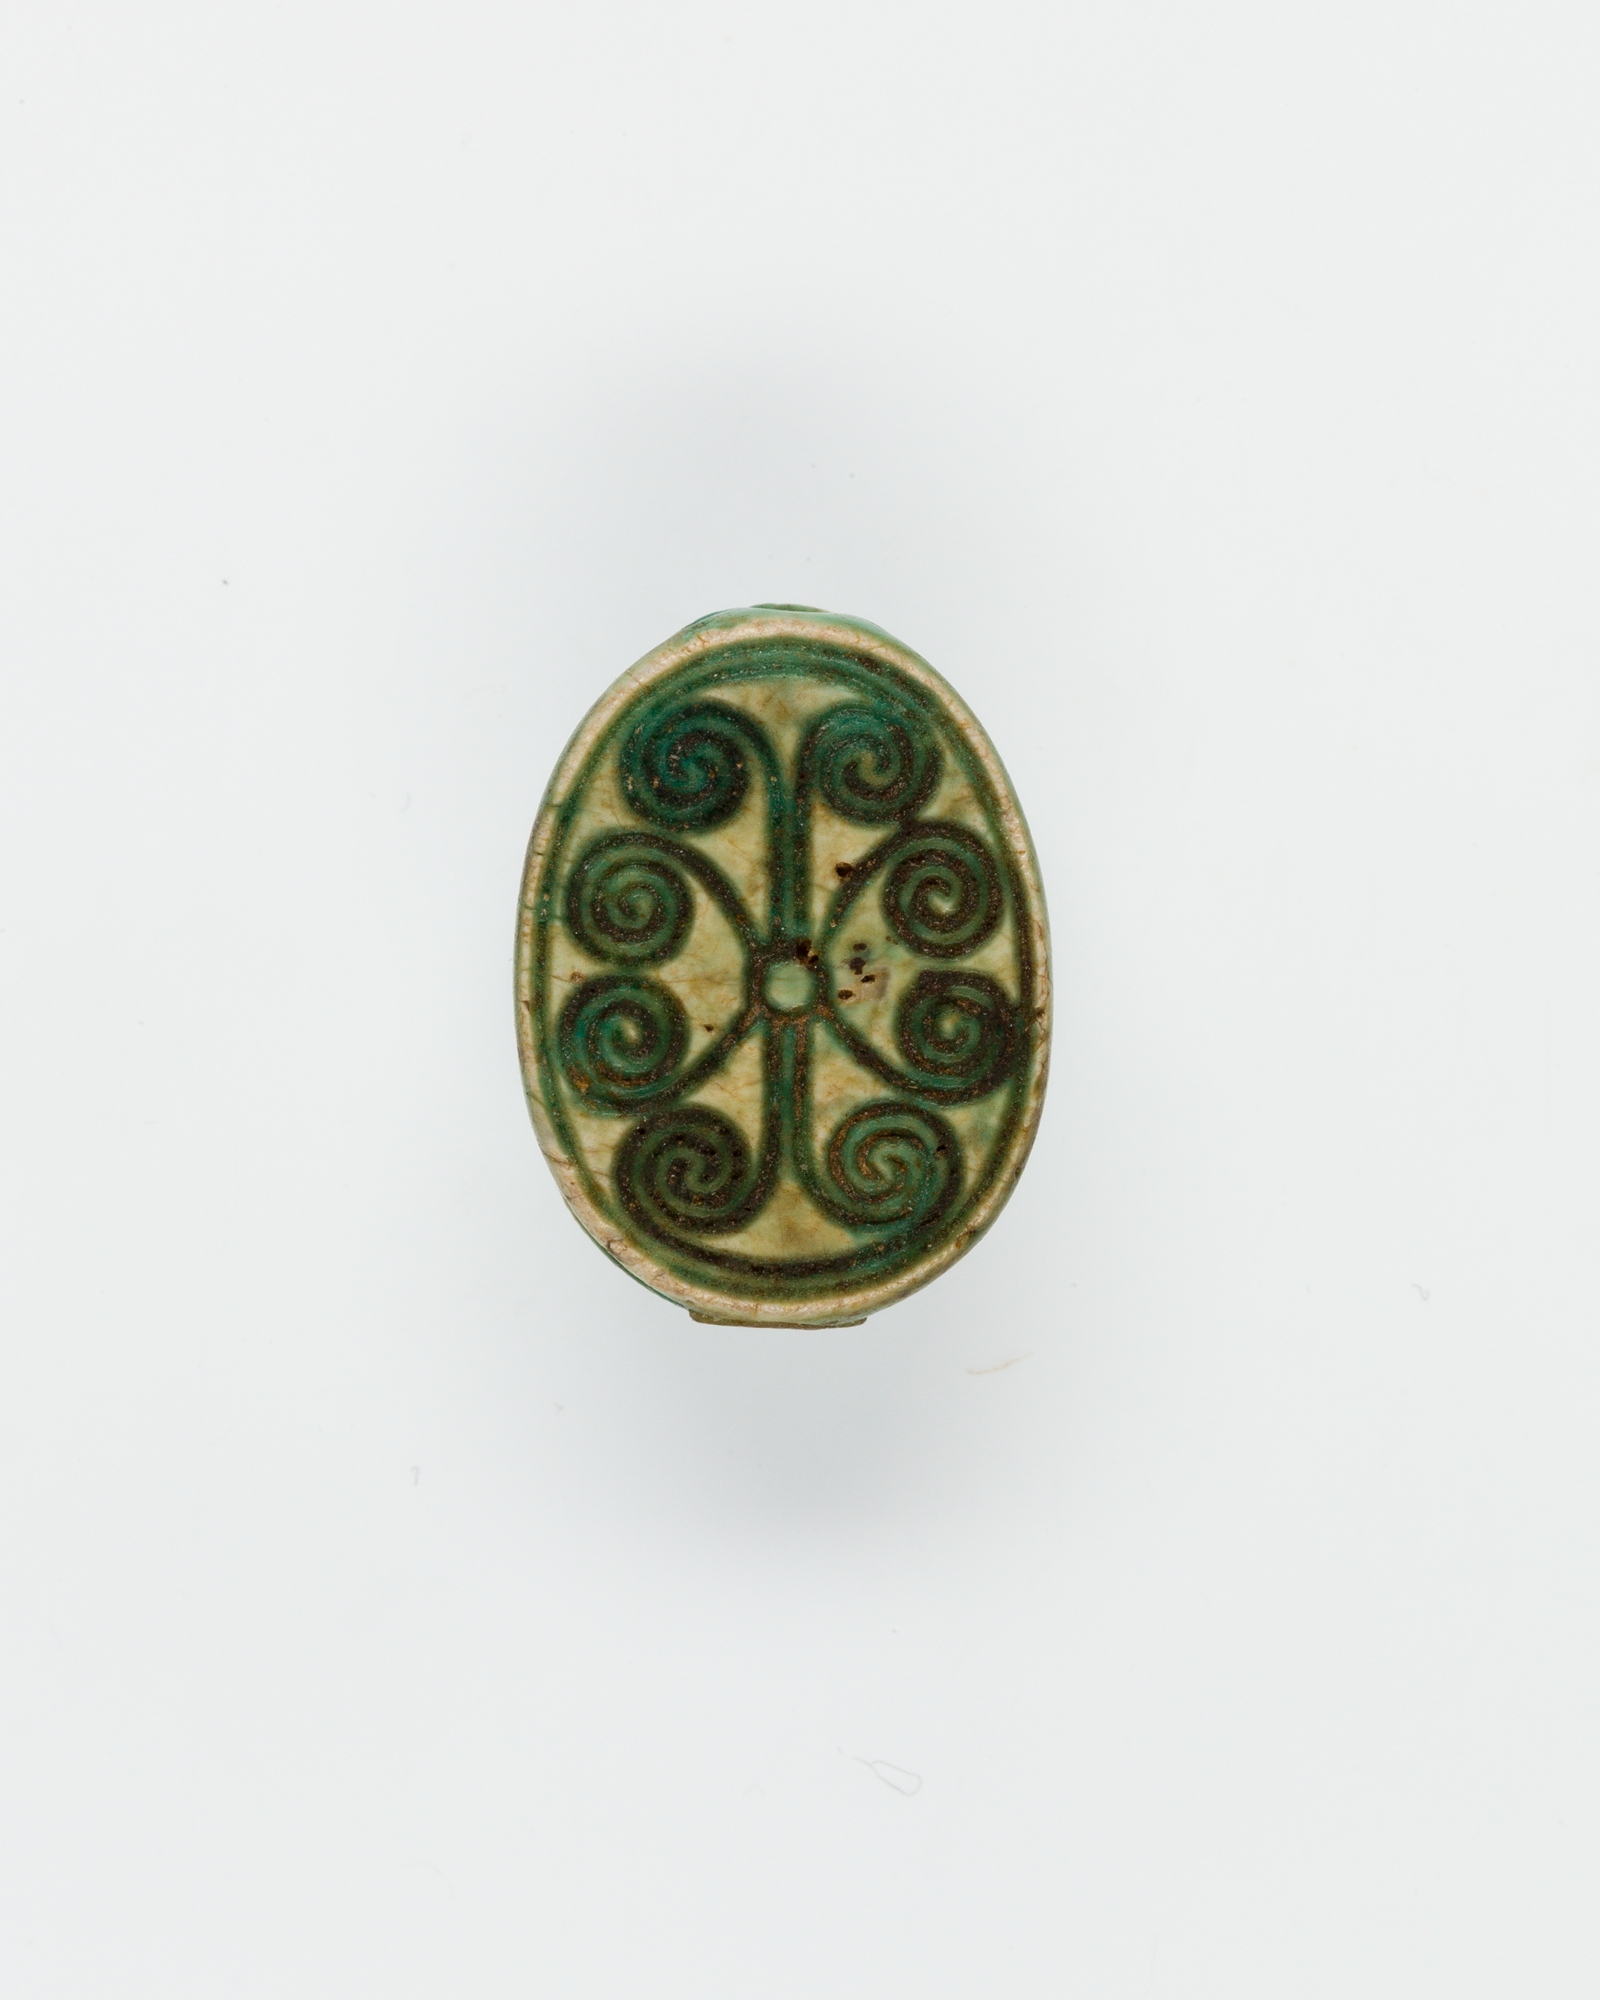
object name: scarab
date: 1492-1479 BCE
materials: stone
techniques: glazing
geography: egypt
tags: scarabs